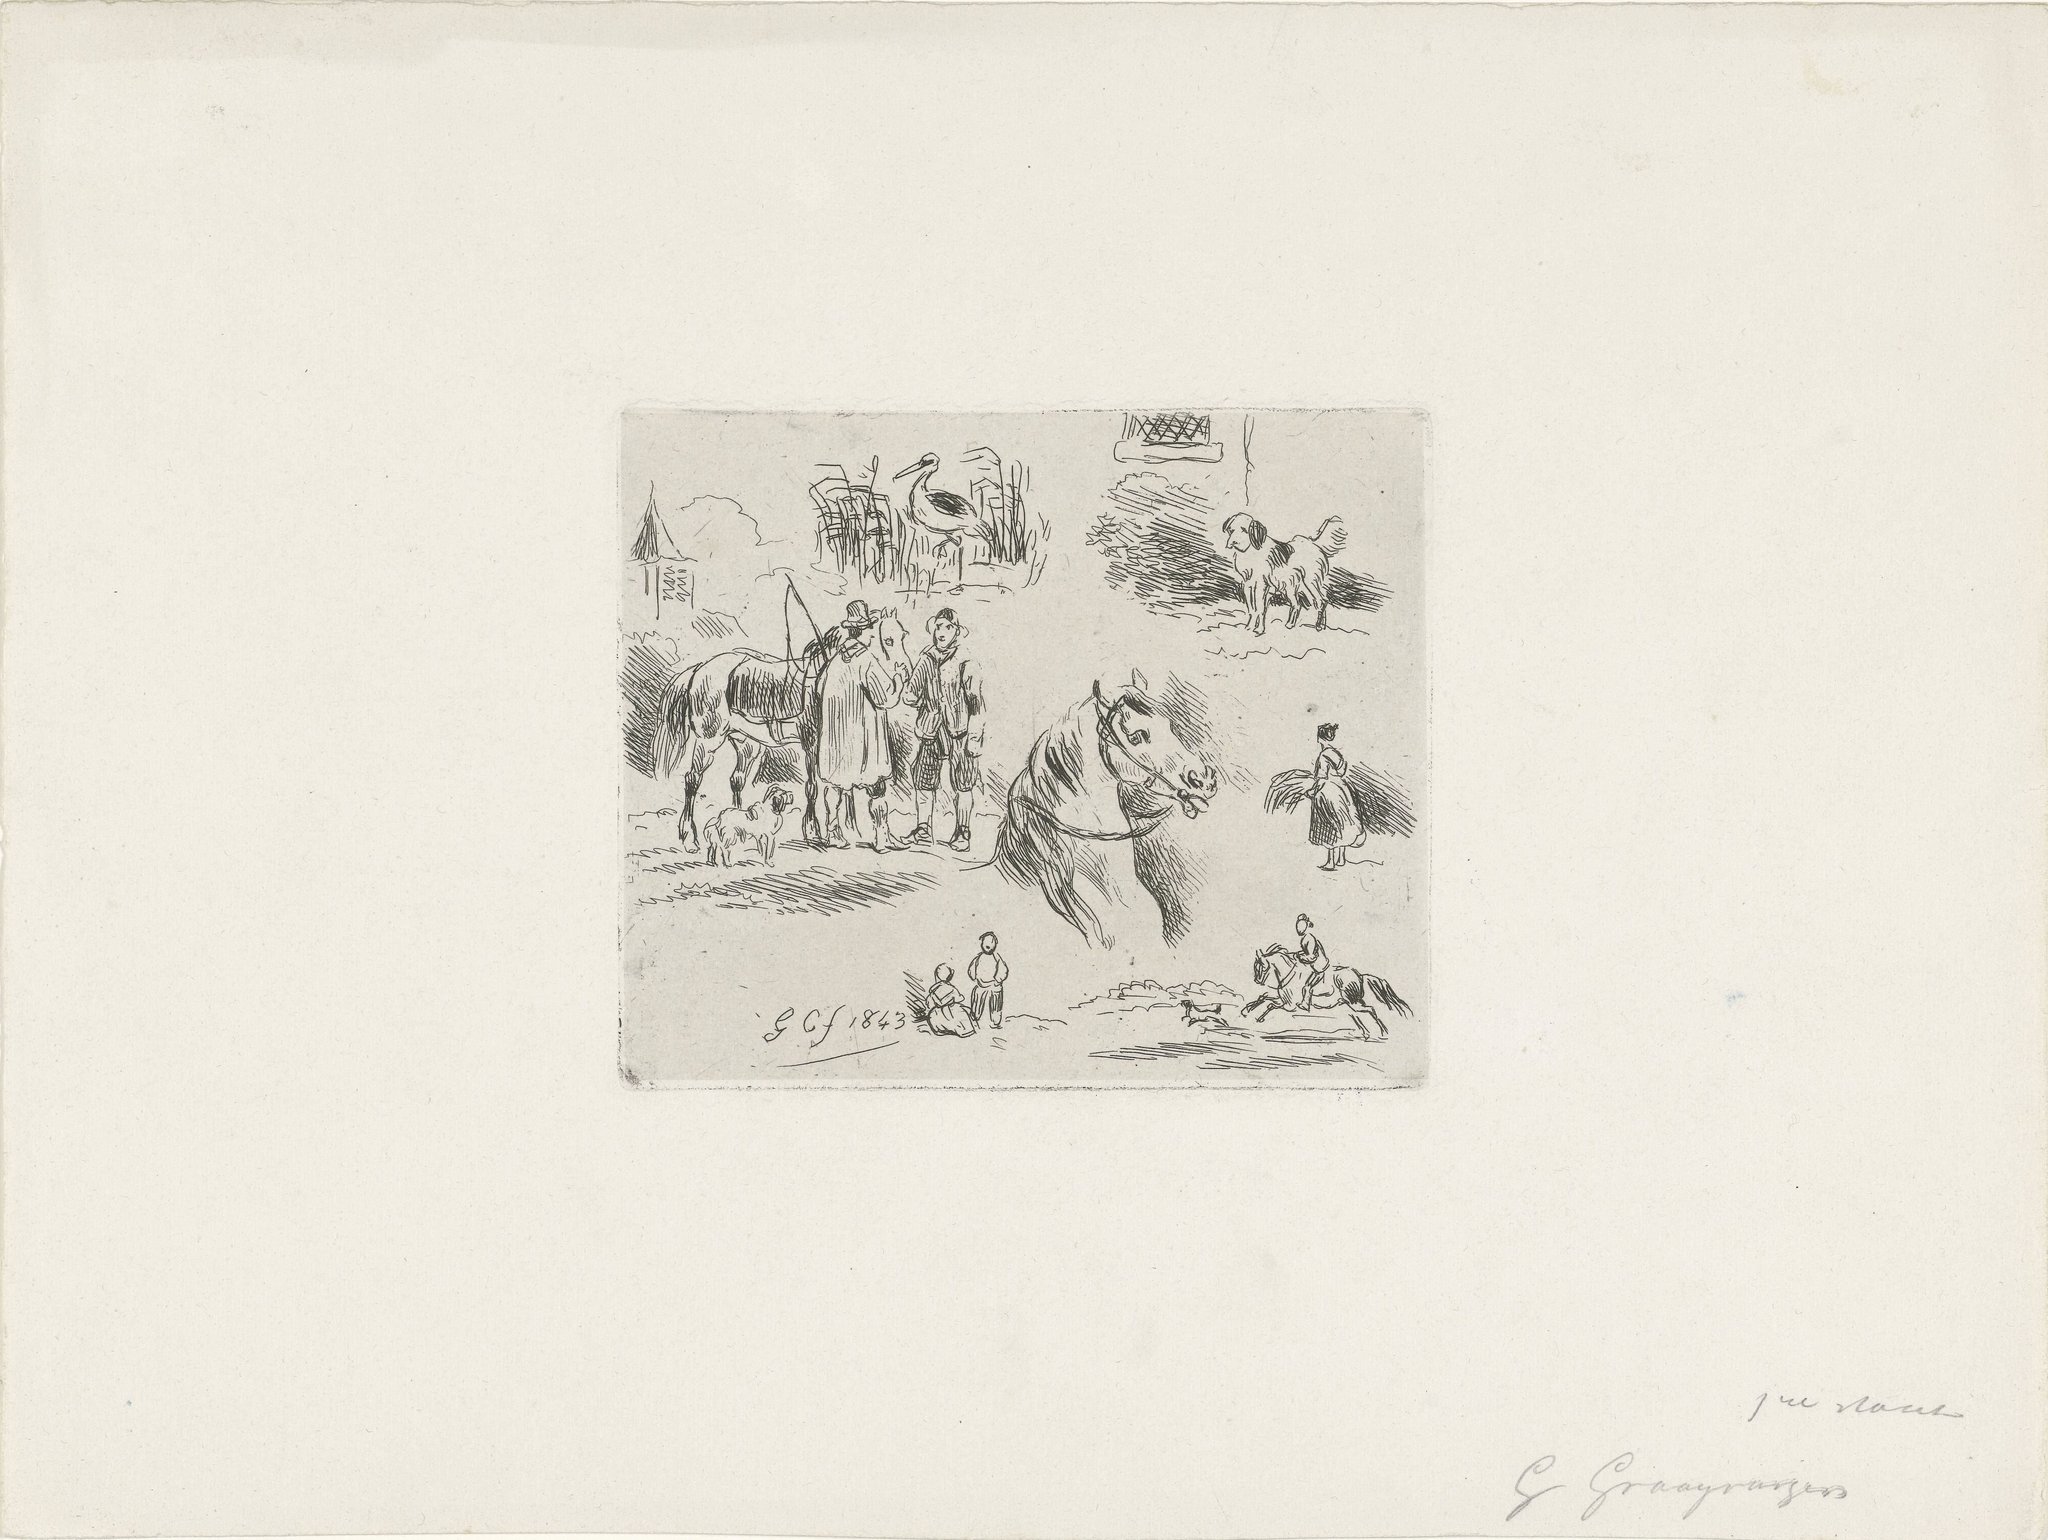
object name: print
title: Studieblad van verschillende figuren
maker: gijsbertus craeyvanger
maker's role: draughtsman, print maker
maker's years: 1810-1895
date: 1843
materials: paper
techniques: etching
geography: utrecht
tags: shore-birds and wading-birds: stork, galloping horse, horse, dog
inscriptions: collector's mark: Lugt 2228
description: Studieblad van zeven verschillende figuren: boven een ooievaar en een hond, midden een keukenmeid, het hoofd van een paard en twee mannen met een paard, onder een galopperend paard en een jong paar.